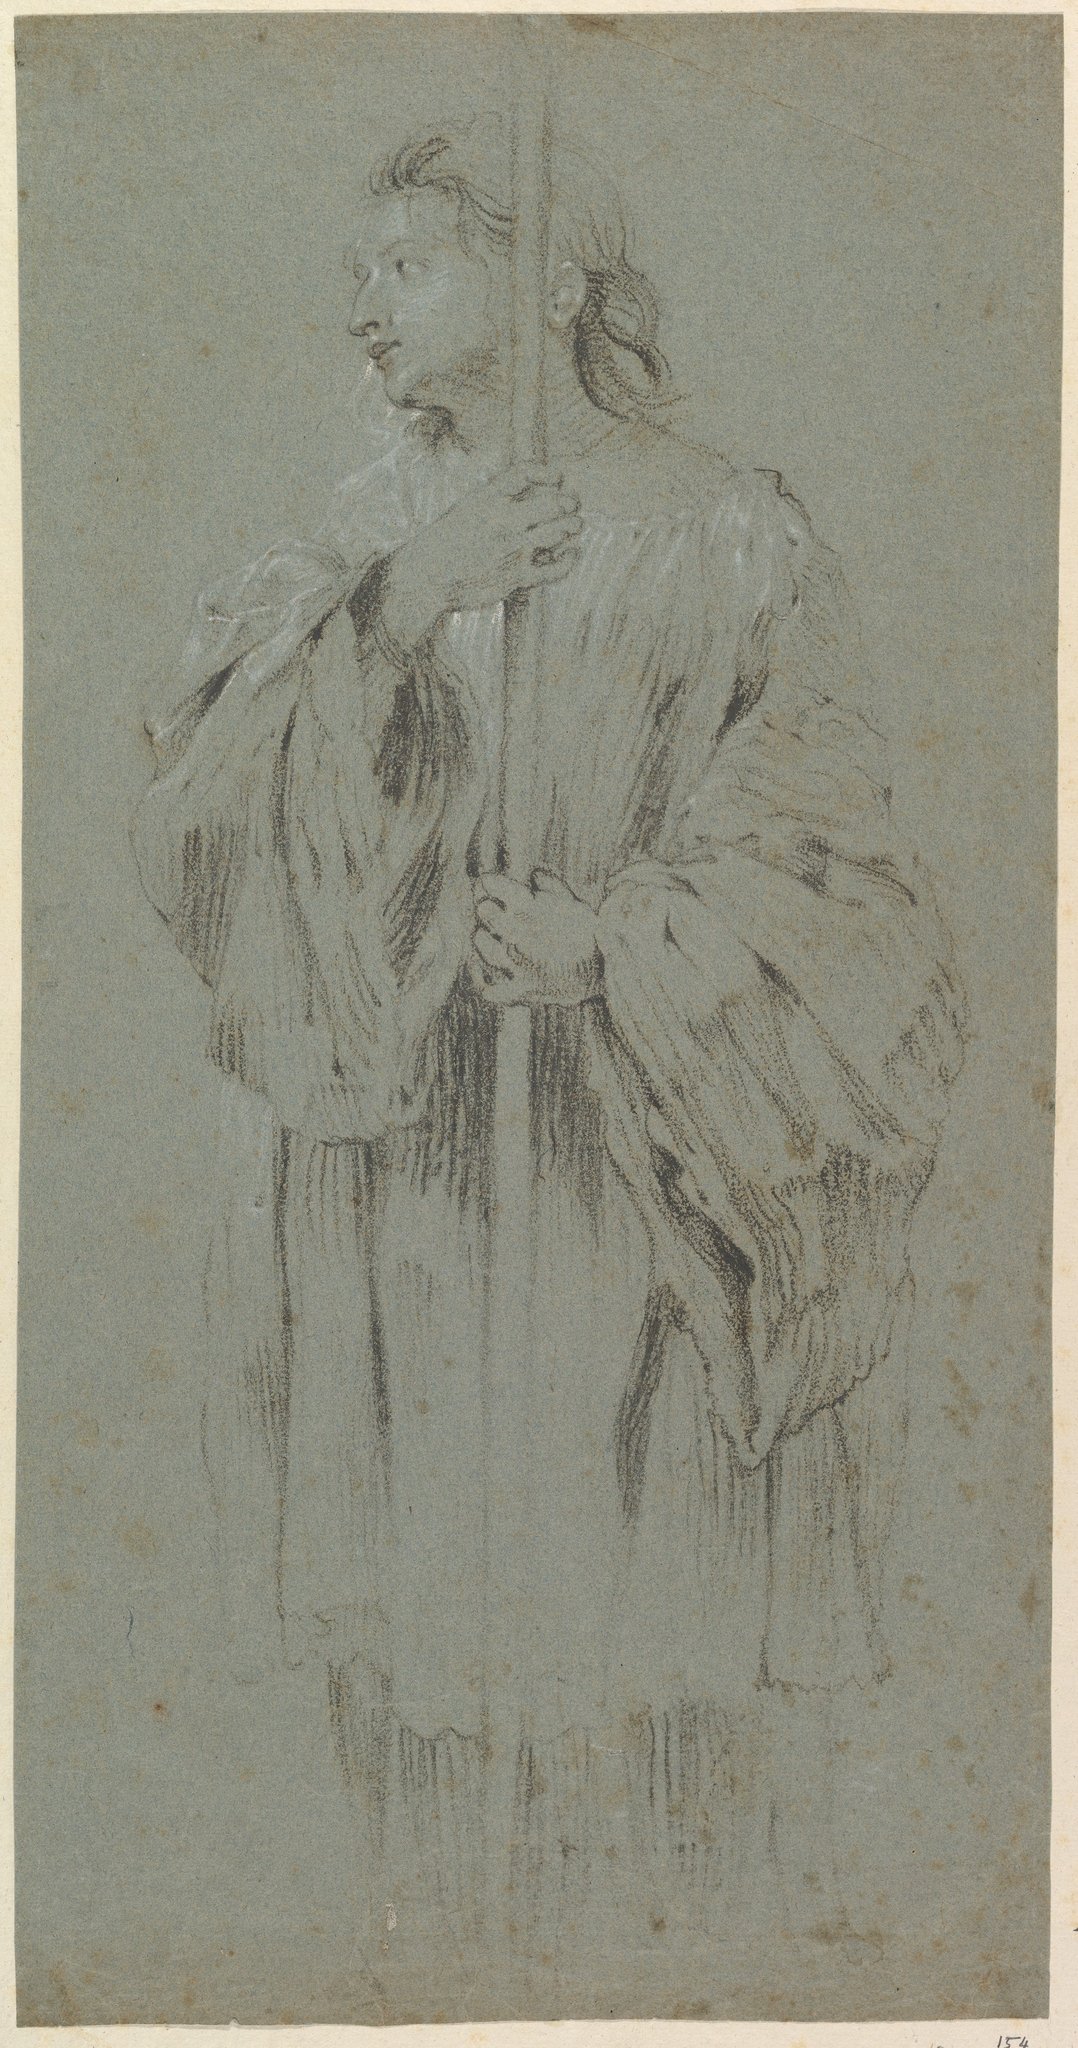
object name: drawing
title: A Young Acolyte Bearing a Staff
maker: anonymous, dutch, 17th century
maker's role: artist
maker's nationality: dutch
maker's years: 1600-1700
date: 1601-1633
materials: chalk, paper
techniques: heightening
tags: men